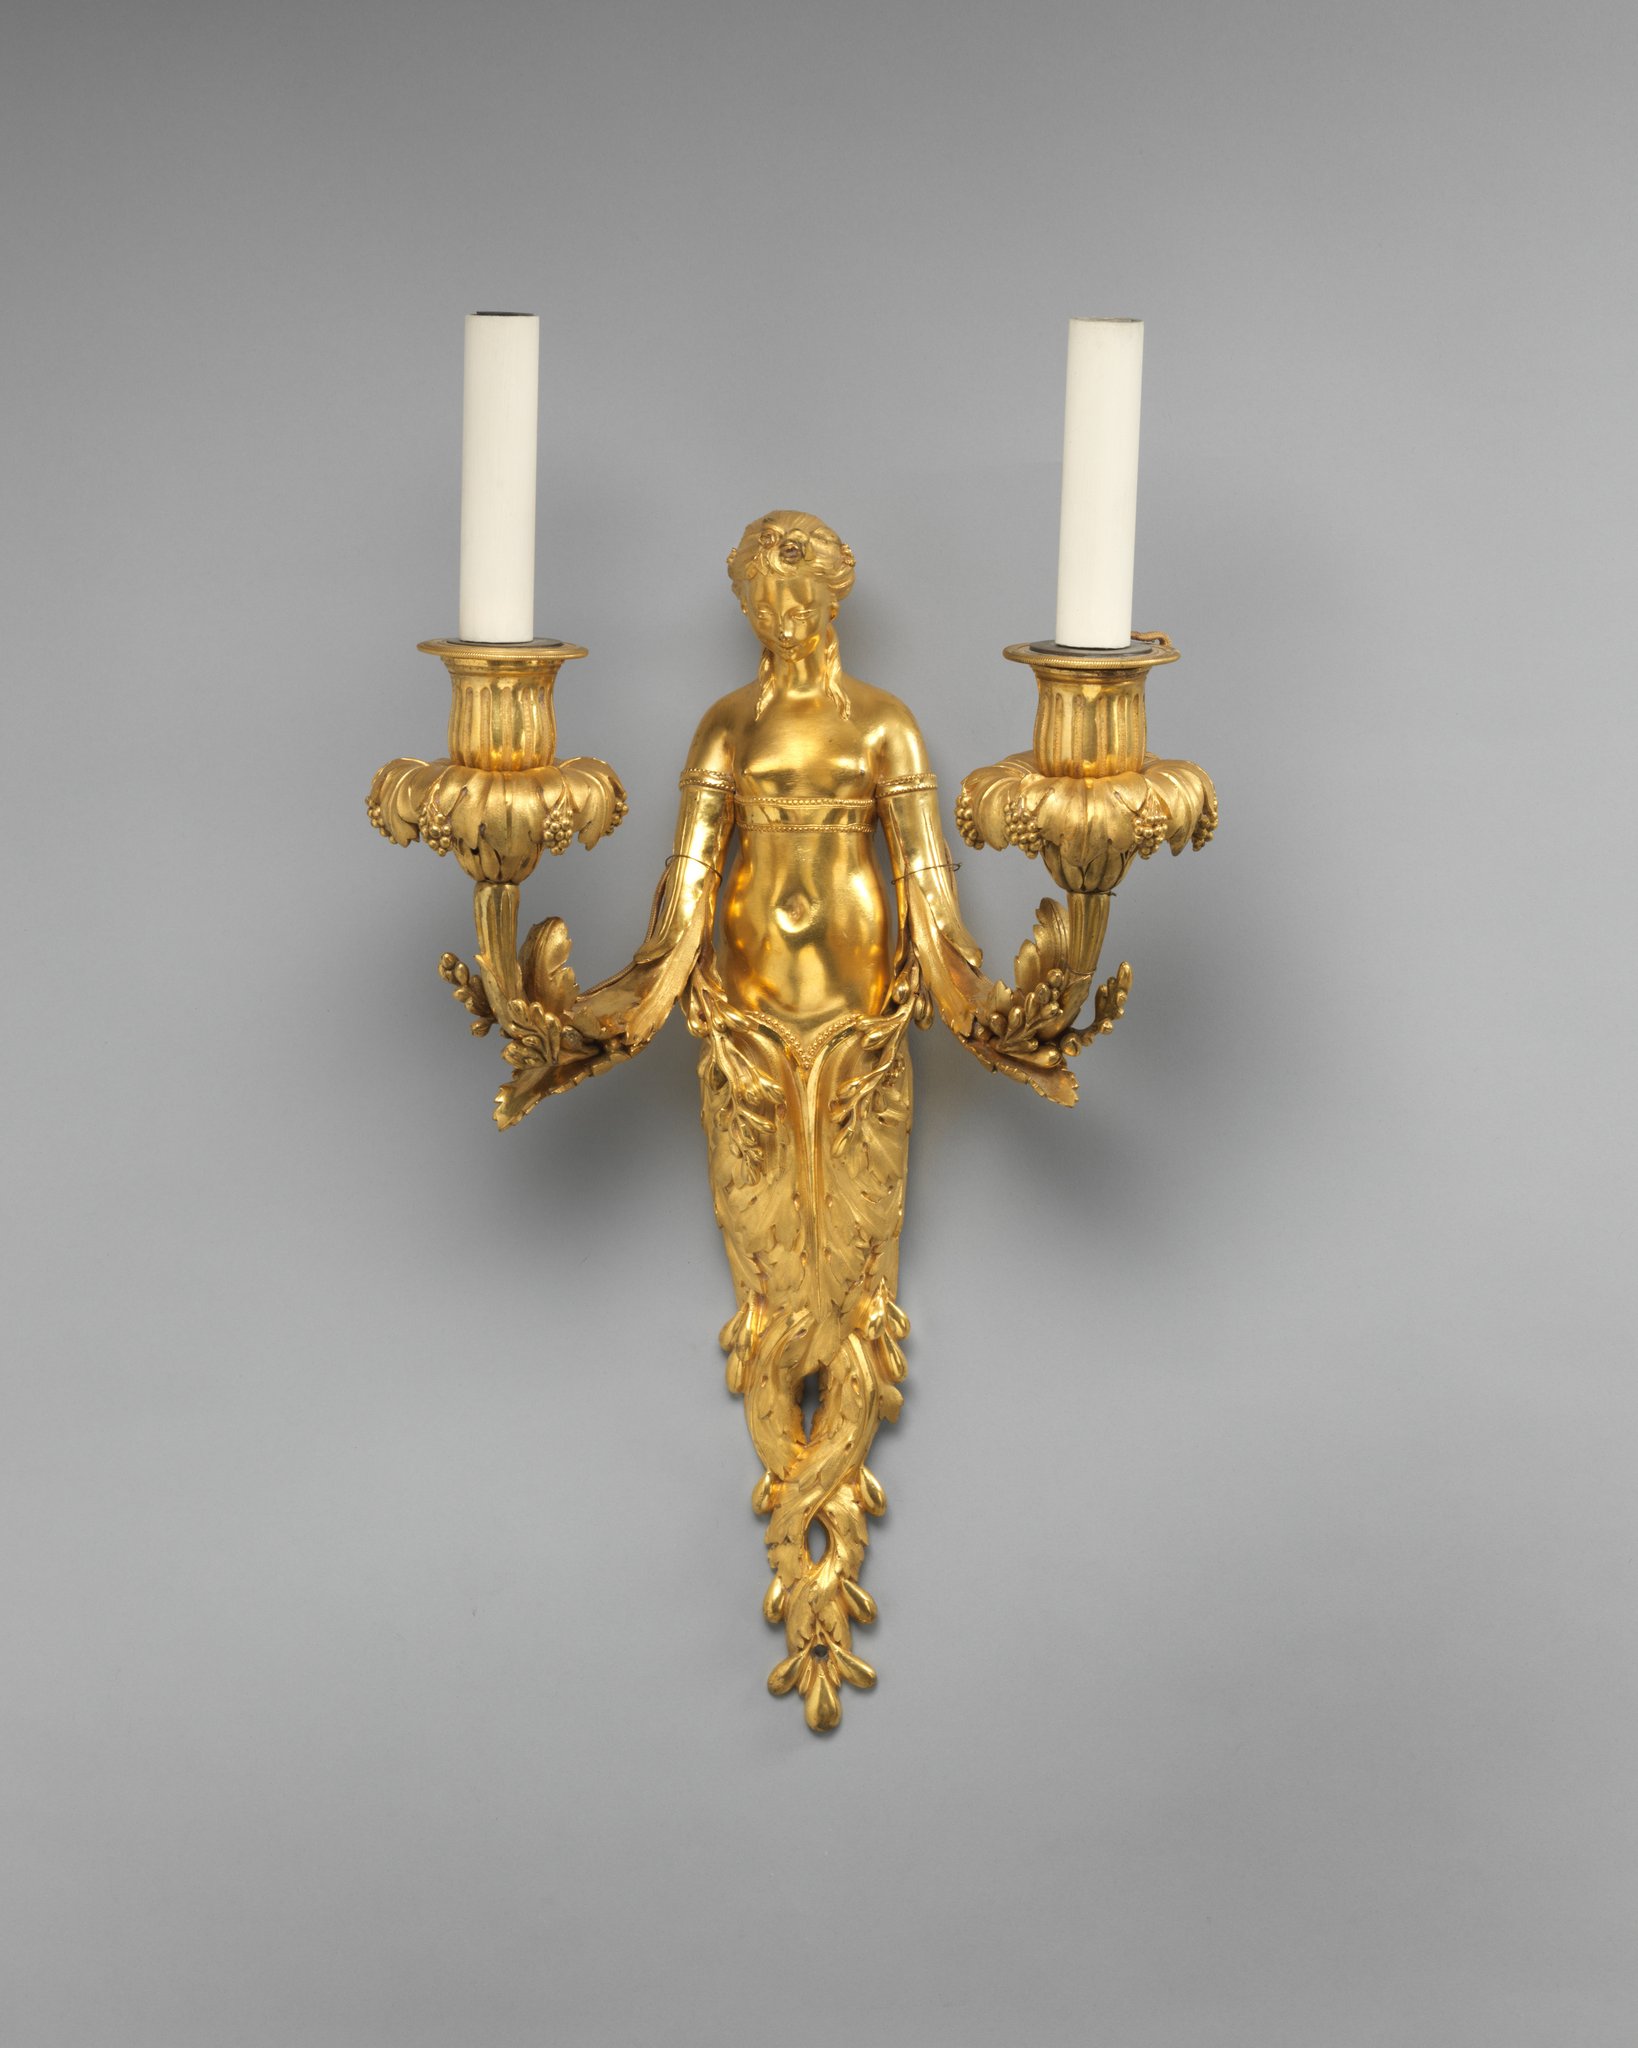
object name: wall light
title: Wall light (bras de lumière) (one of a pair)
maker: robert joseph auguste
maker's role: maker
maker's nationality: french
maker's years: 1723-1805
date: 1775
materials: bronze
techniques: gilding